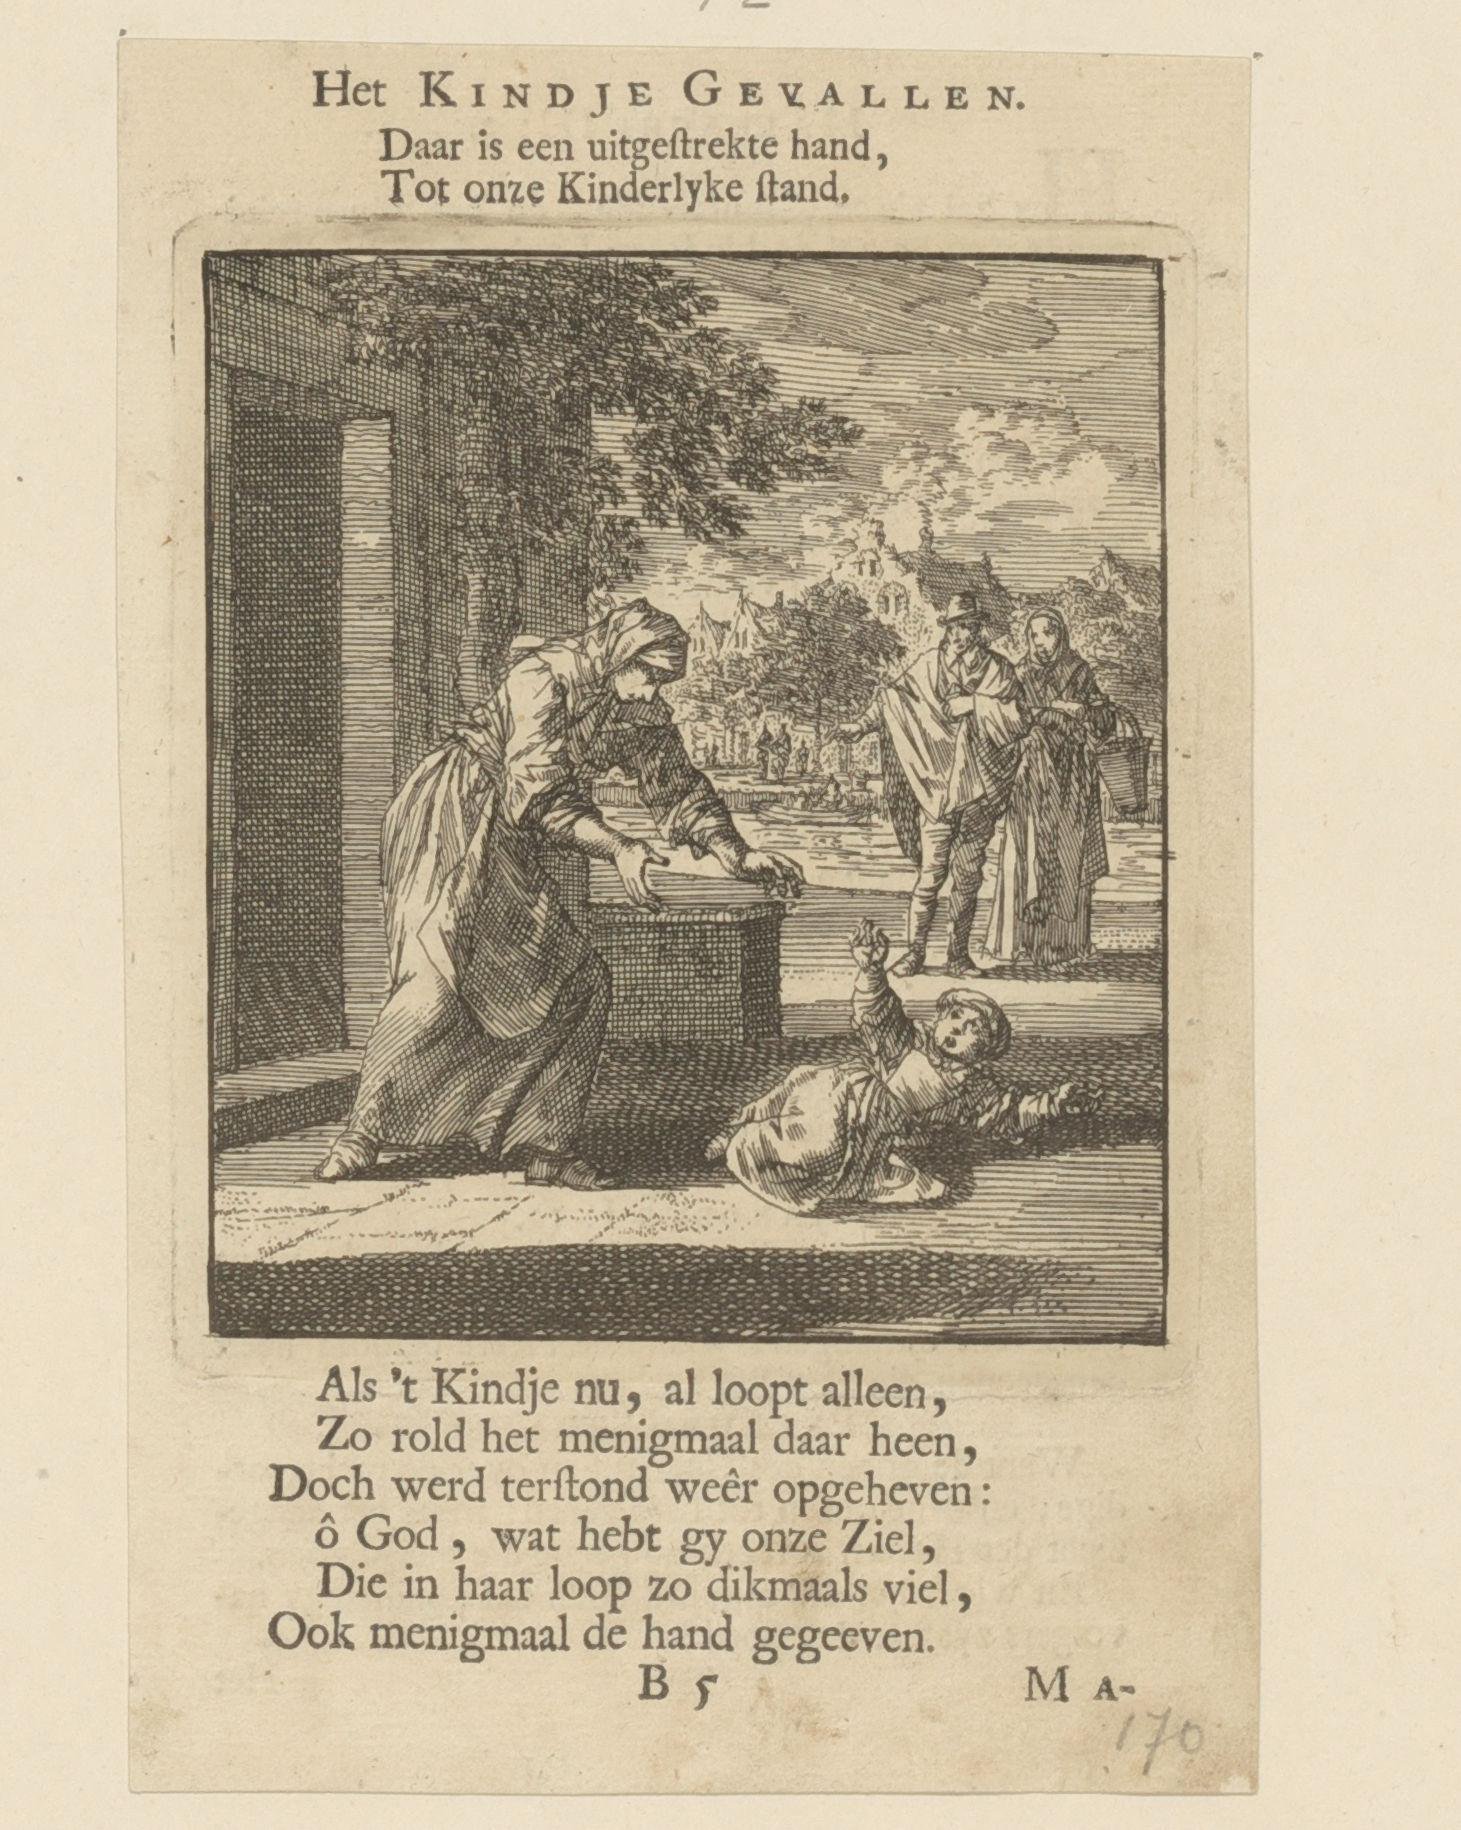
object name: print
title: Moeder tilt haar op de grond gevallen kind op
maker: jan luyken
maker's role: draughtsman, print maker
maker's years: 1649-1712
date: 1712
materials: paper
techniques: etching, letterpress printing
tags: mother and baby or young child, falling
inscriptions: collector's mark: Lugt 1641, stamp, stamp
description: Onderaan een zesregelig vers. Onderwerpsrubrieken binnen de Atlas Zeden en Gewoonten: Zeden en Gewoonten in Engeren Zin, Des menschen beging, midden en einde, Kinderleven – Kinderspel en Kinderprenten.